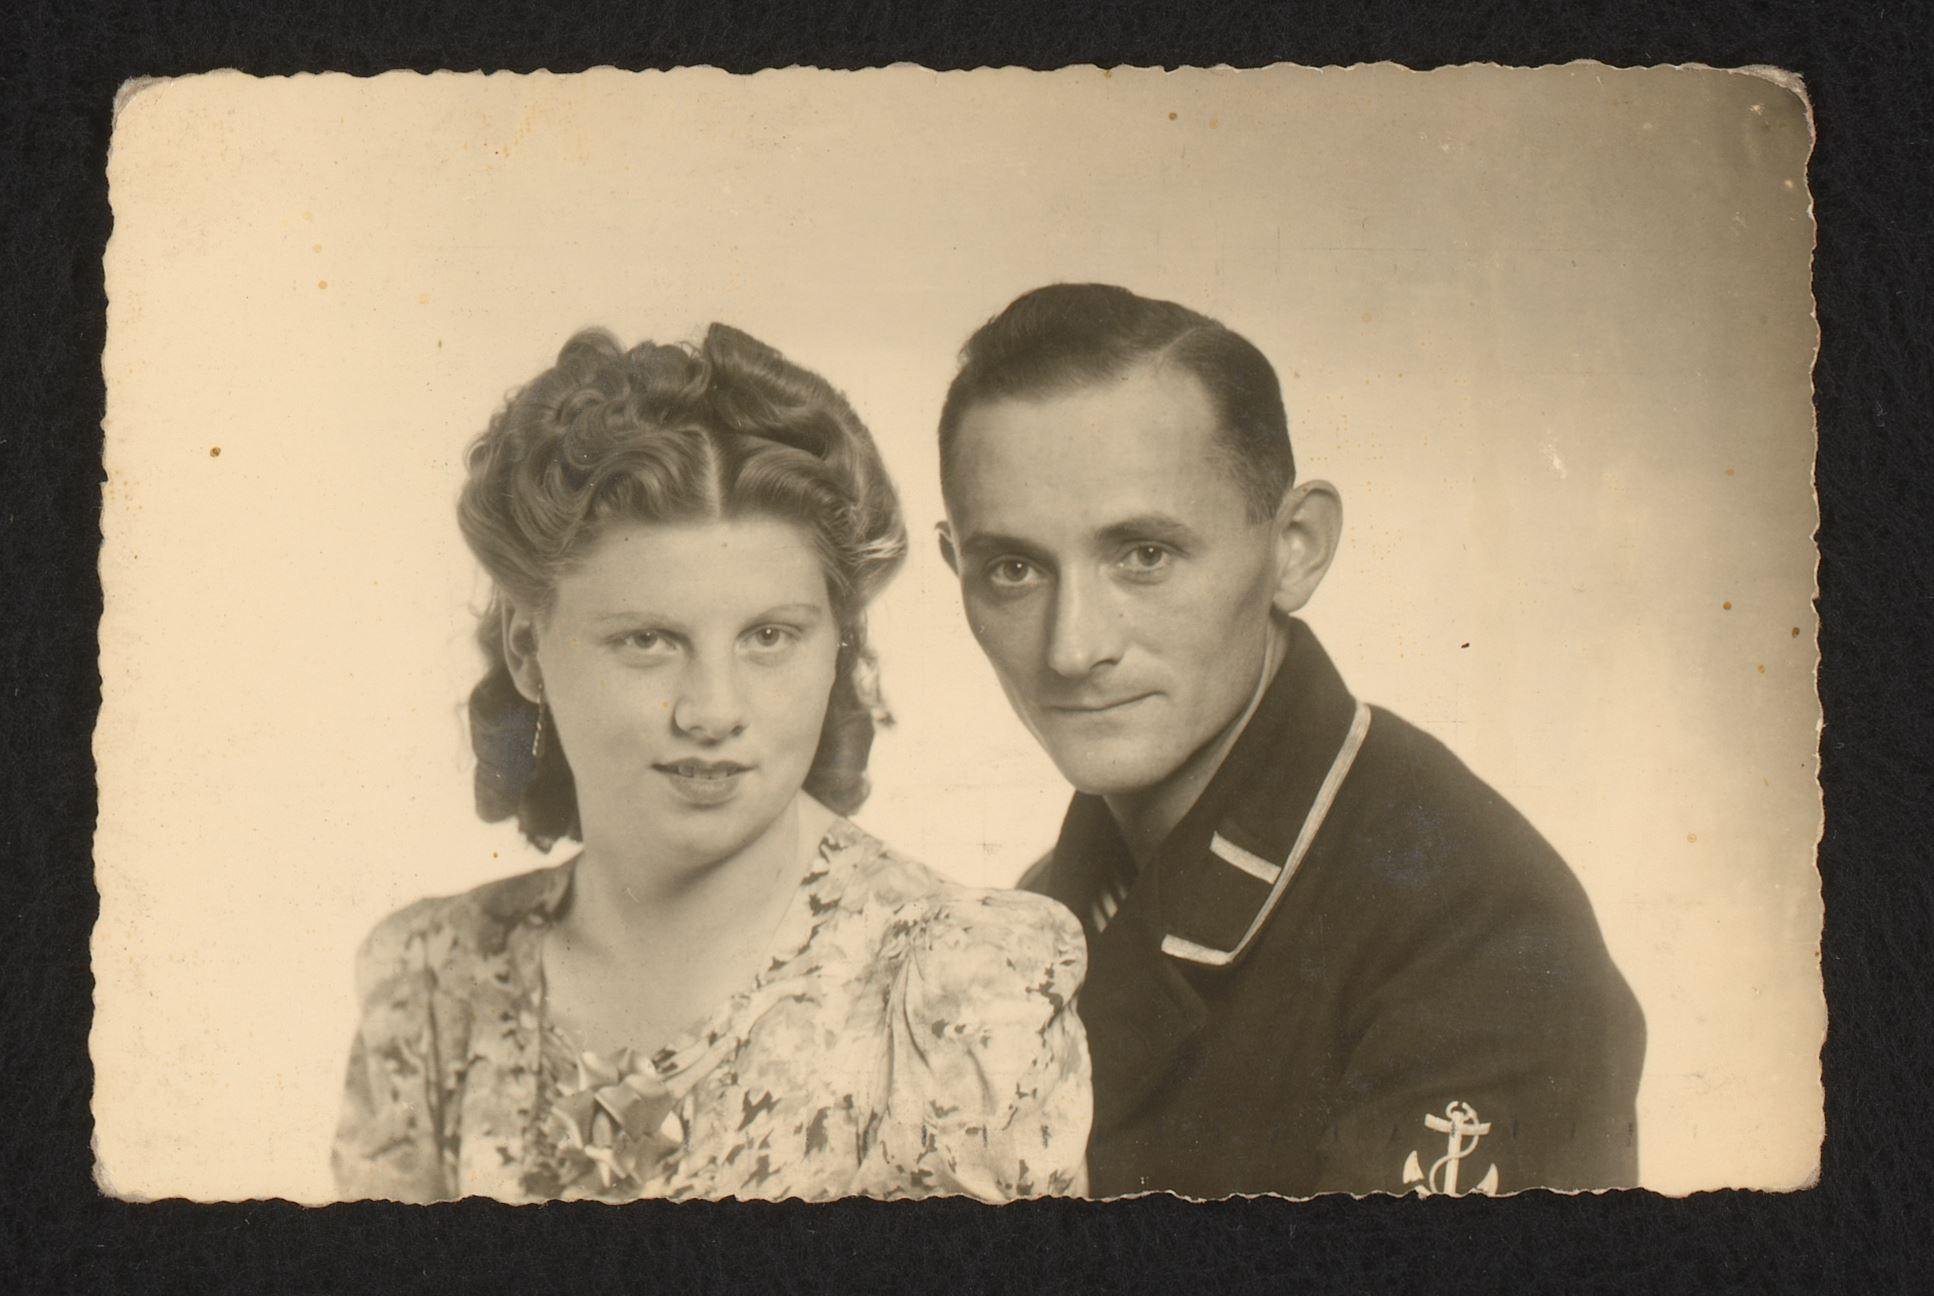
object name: photograph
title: Thea en Werner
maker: Anonymous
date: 1941-1944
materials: paper, photographic support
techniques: gelatin silver print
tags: werner neufang, lovers; courting, flirting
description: Thea en Werner. Onderdeel van de groep losse foto's behorend bij het fotoalbum over de Duitse Werner Neufang van de Kriegsmarine en de Nederlandse Thea Driesen.